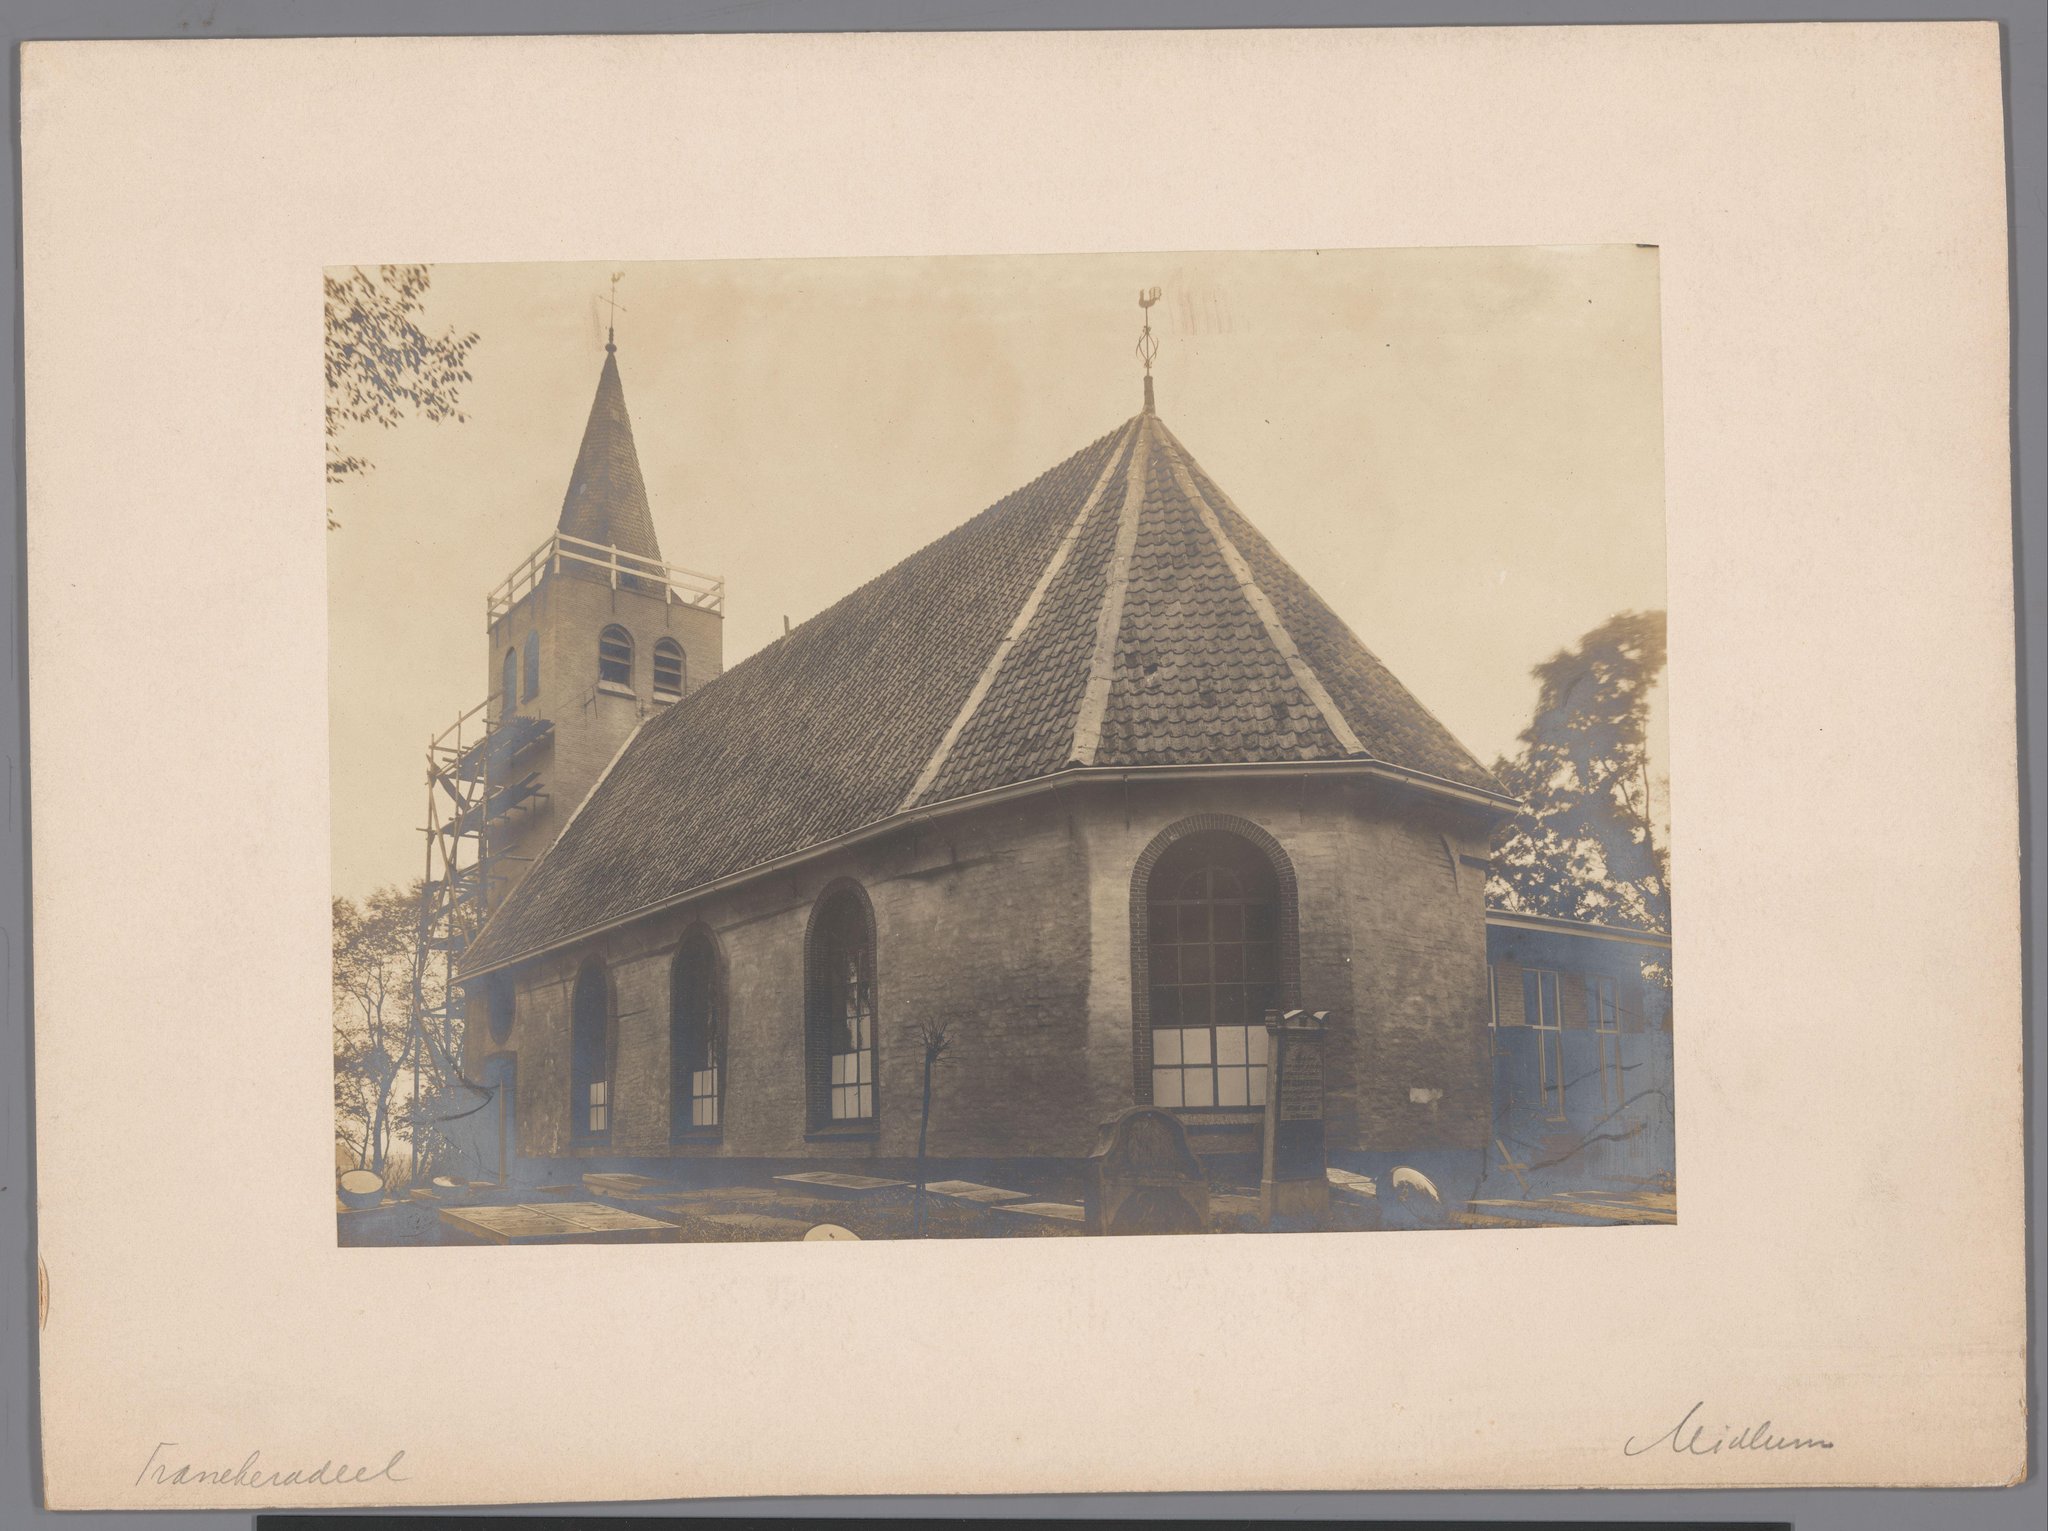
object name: photograph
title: Nicolaaskerk te Midlum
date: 1907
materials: cardboard, photographic support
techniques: gelatin silver print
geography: midlum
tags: church (exterior)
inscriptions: annotation: ‘Midlum bij Franeker (Fr) / Ned Herv Kerk / oct 1907’, annotation: ‘Franekeradeel/ Midlum’